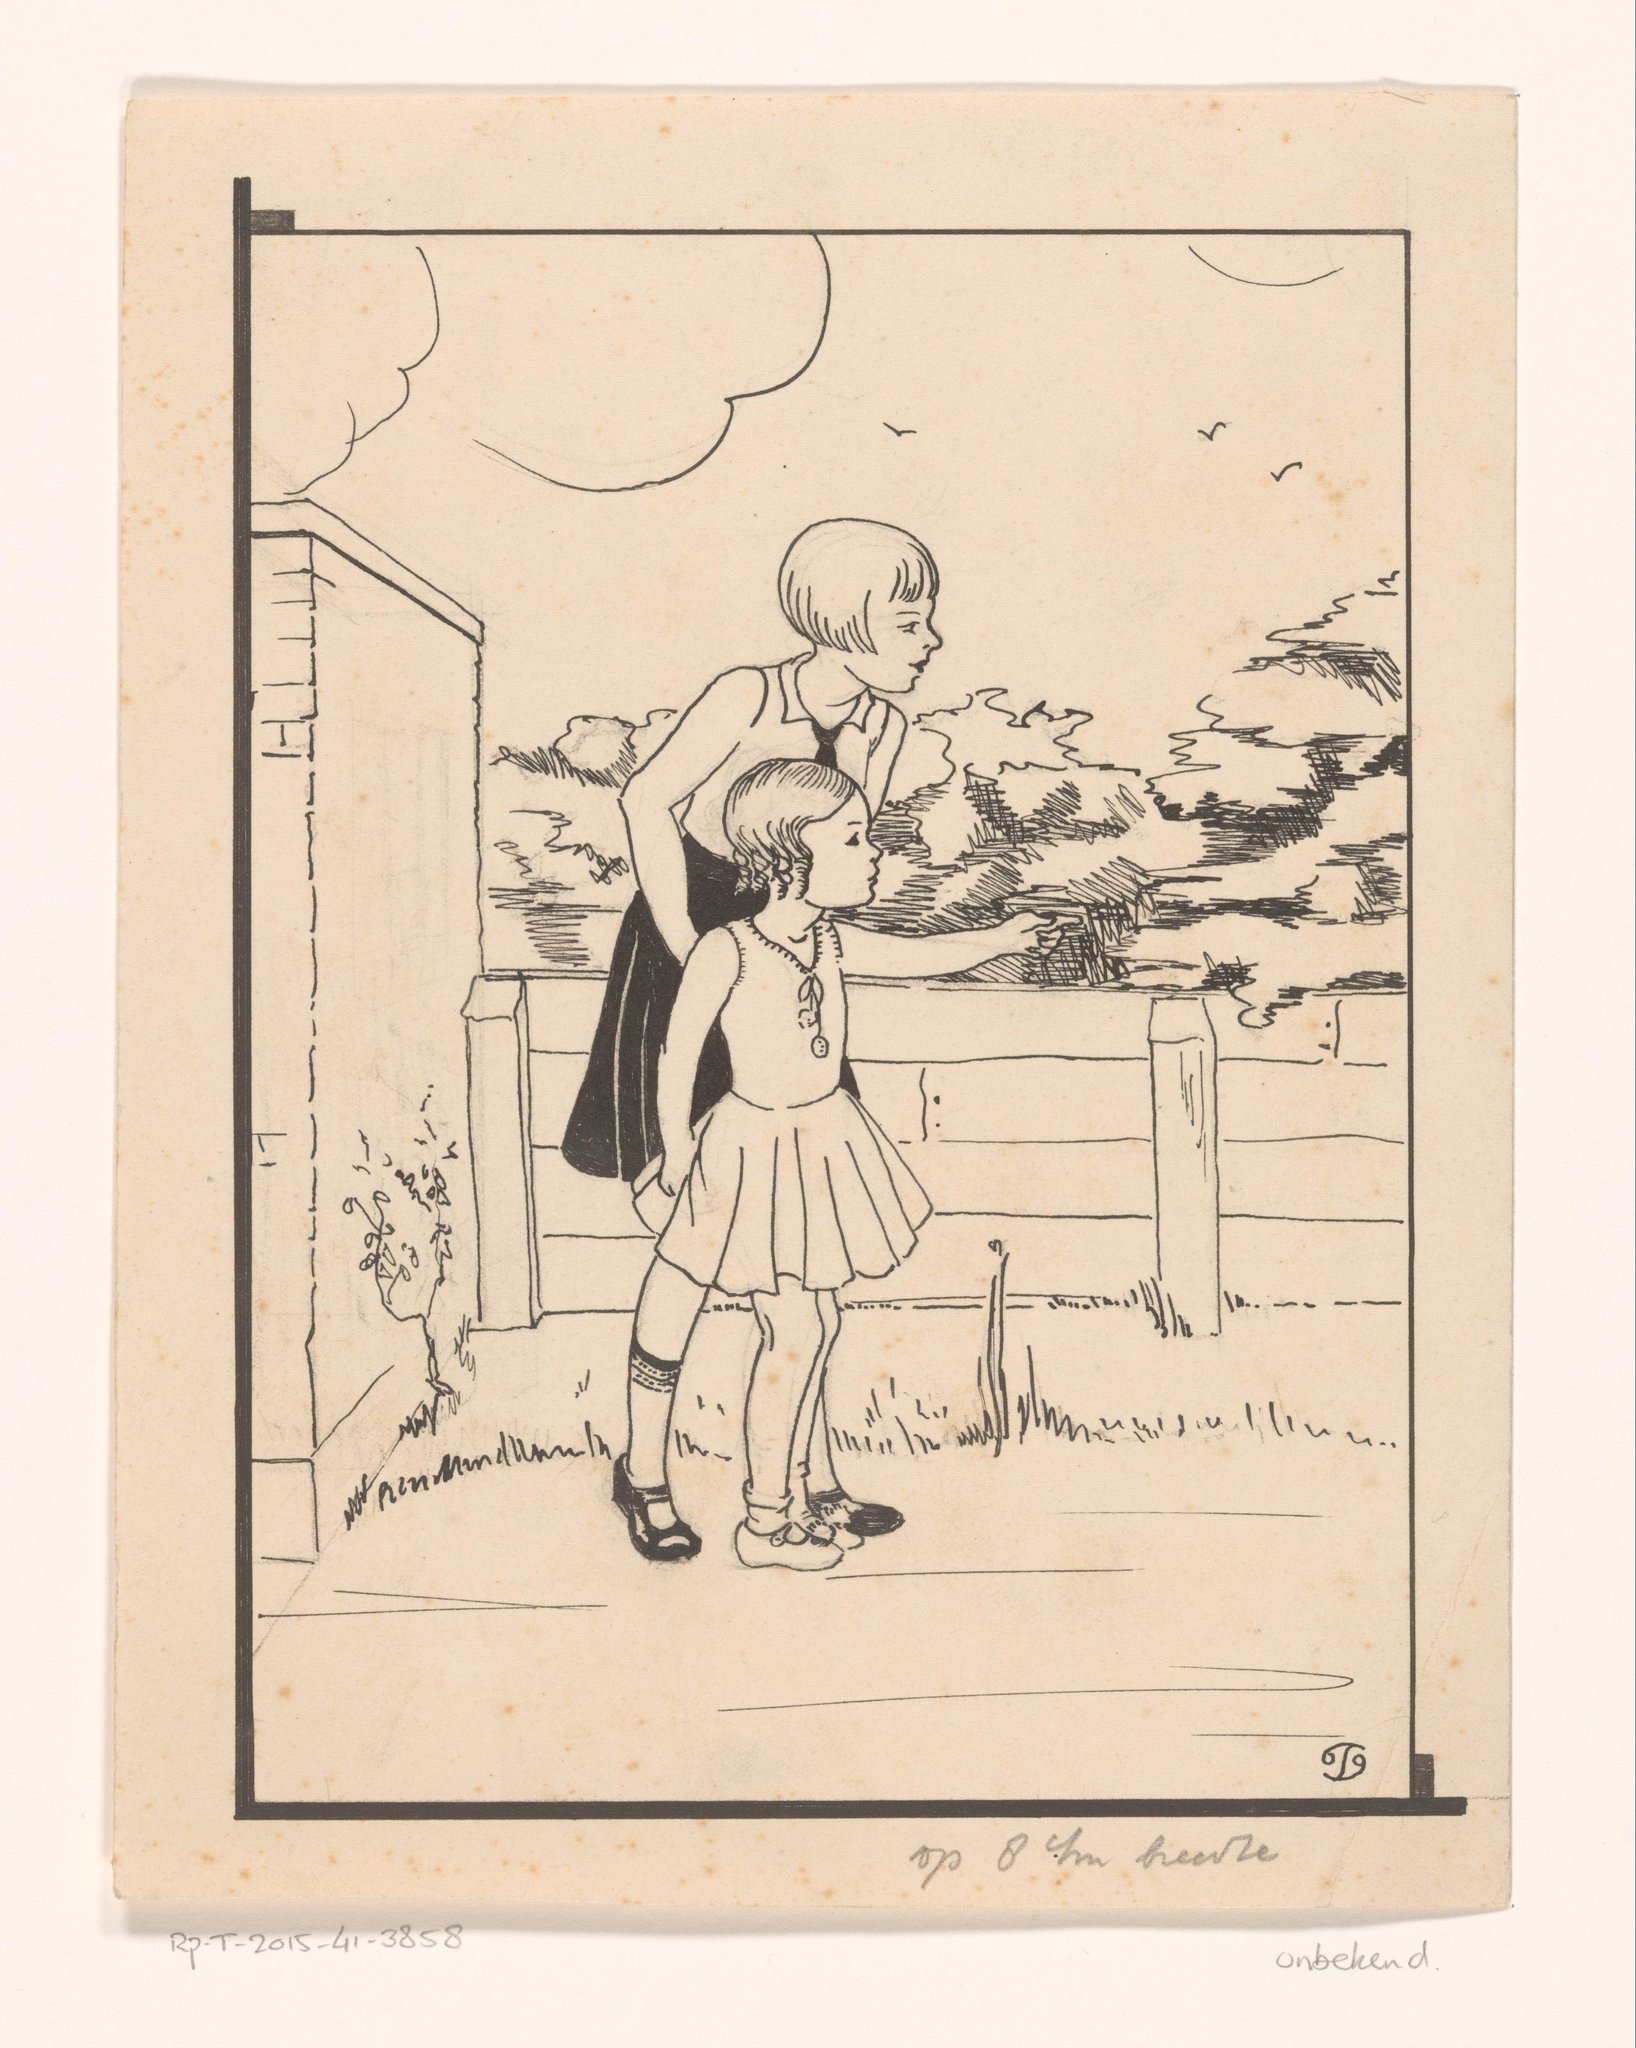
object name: drawing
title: Twee meisjes in een tuin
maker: Anonymous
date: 1890-1940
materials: ink, paper, pencil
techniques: brush, pen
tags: garden, index finger forwards, pointing, indicating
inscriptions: monogram, annotation: ‘De draad.’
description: Twee meisjes staan voor een hek in een tuin. Het jongste meisje wijst met haar linkerhand in de verte.